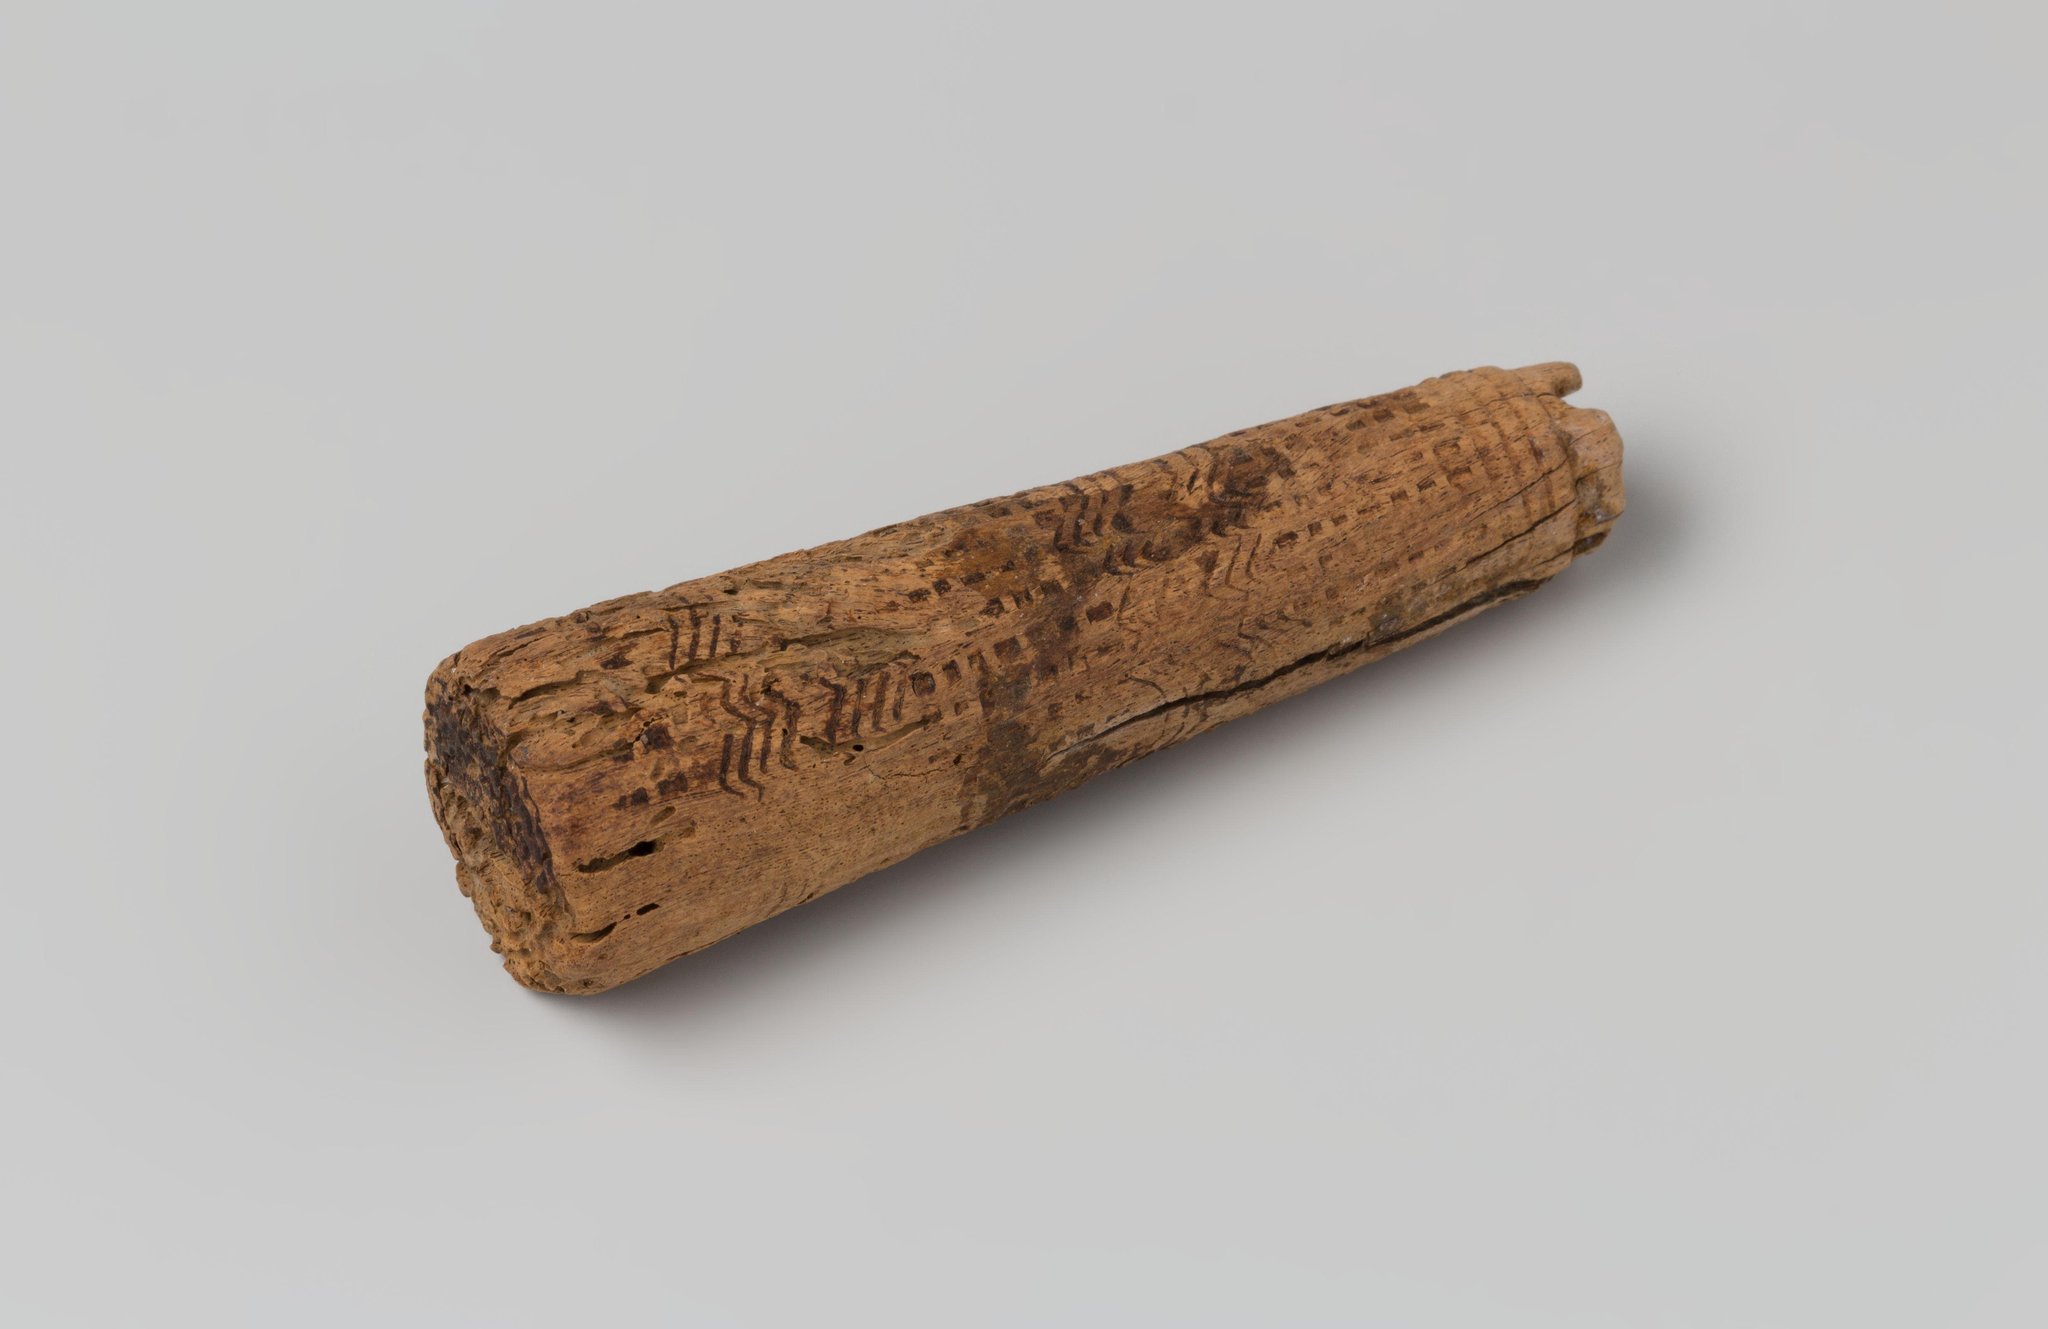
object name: knife handle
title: Messenheft uit het wrak van de Oost-Indiëvaarder Hollandia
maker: Anonymous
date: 1700-1743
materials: wood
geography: netherlands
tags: verenigde oostindische compagnie, hollandia (schip), annet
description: Knife, handle, cylindrical: tapering; id. NG 1979-403H.